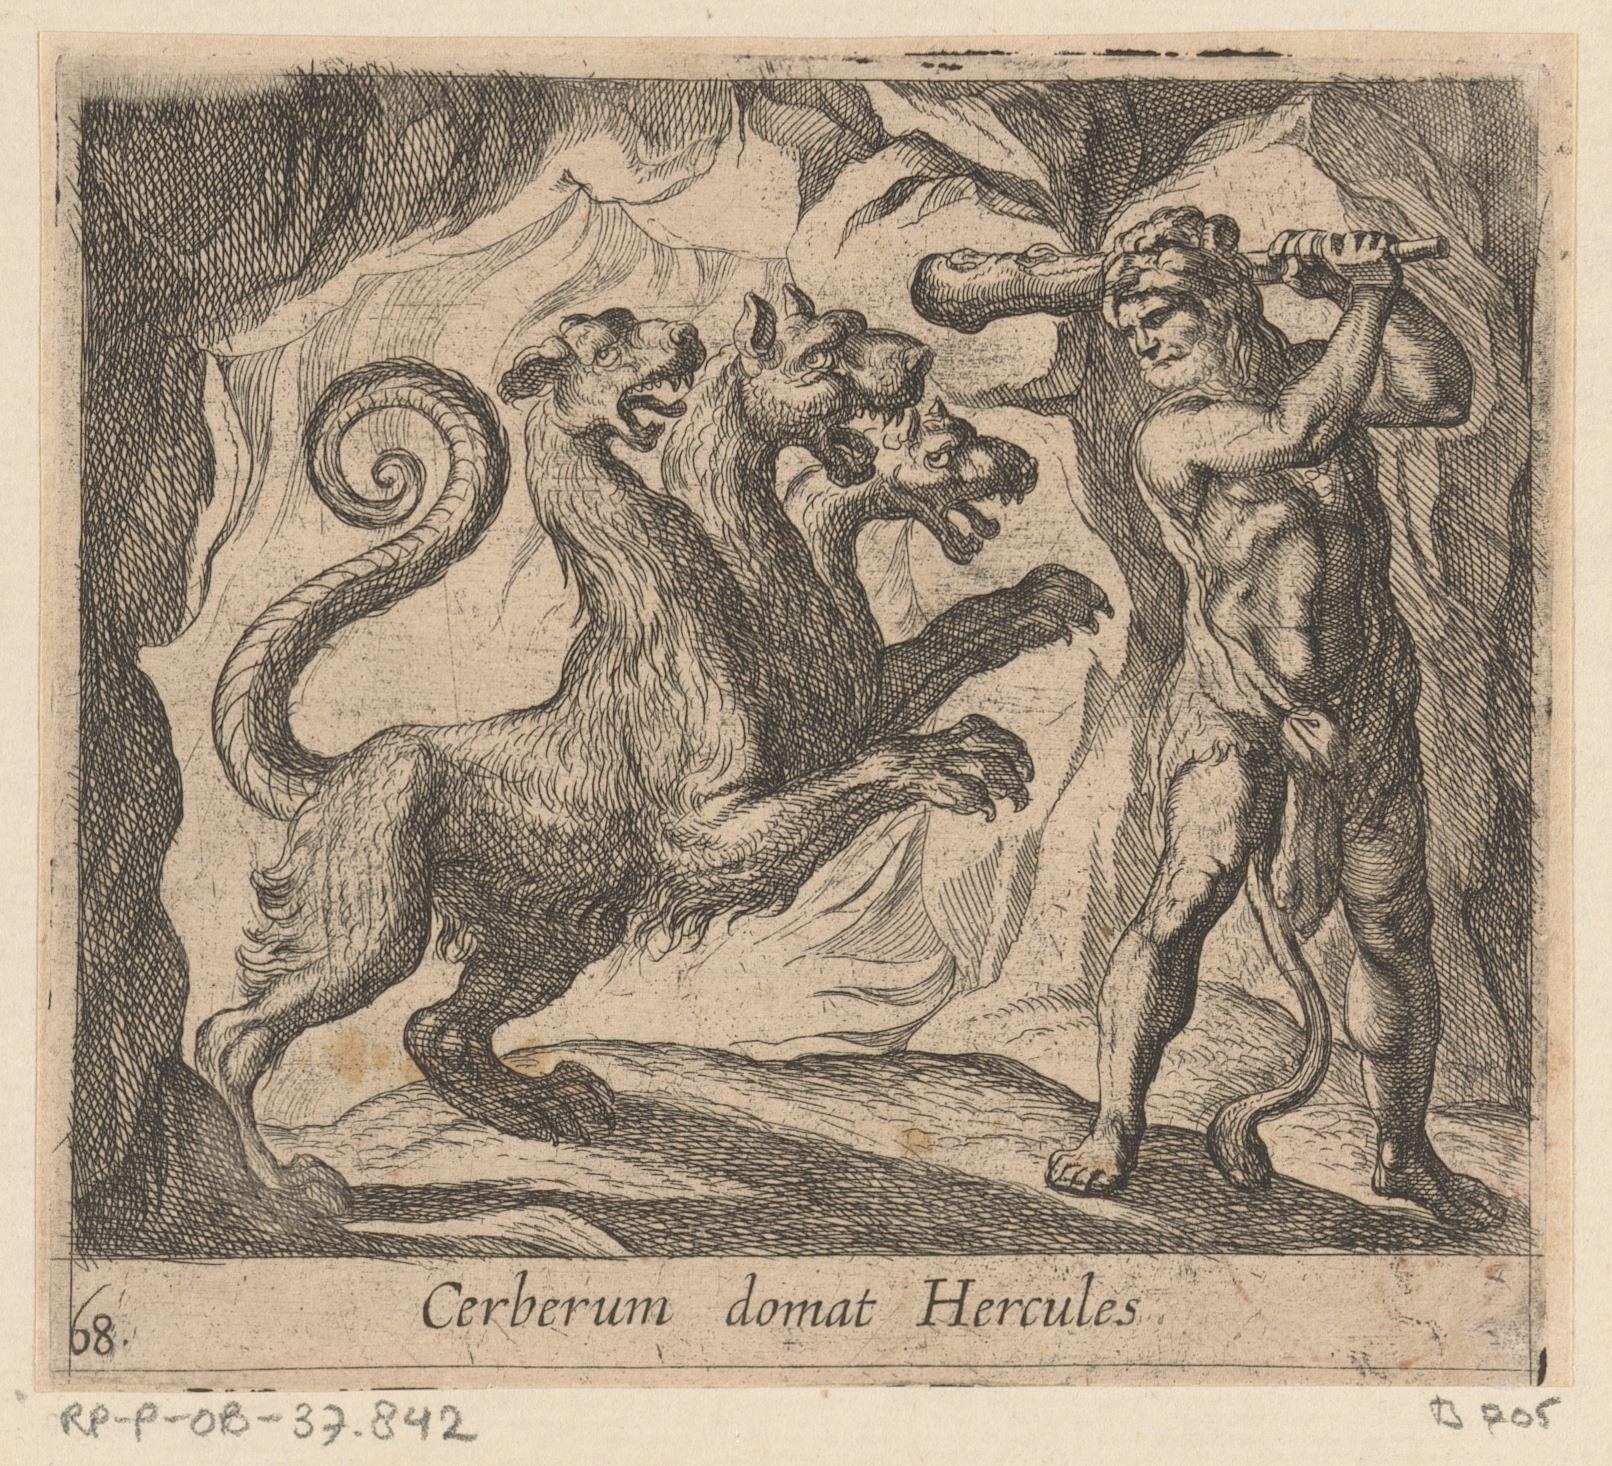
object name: print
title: Hercules en Cerberus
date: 1606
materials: paper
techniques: etching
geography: antwerp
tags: (12) cerberus captured and carried away by hercules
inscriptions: collector's mark: Lugt 240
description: Hercules staat met opgeheven knots voor Cerberus, de driekoppige hond die de ingang van de Hades bewaakt. Titel in het Latijn in ondermarge.